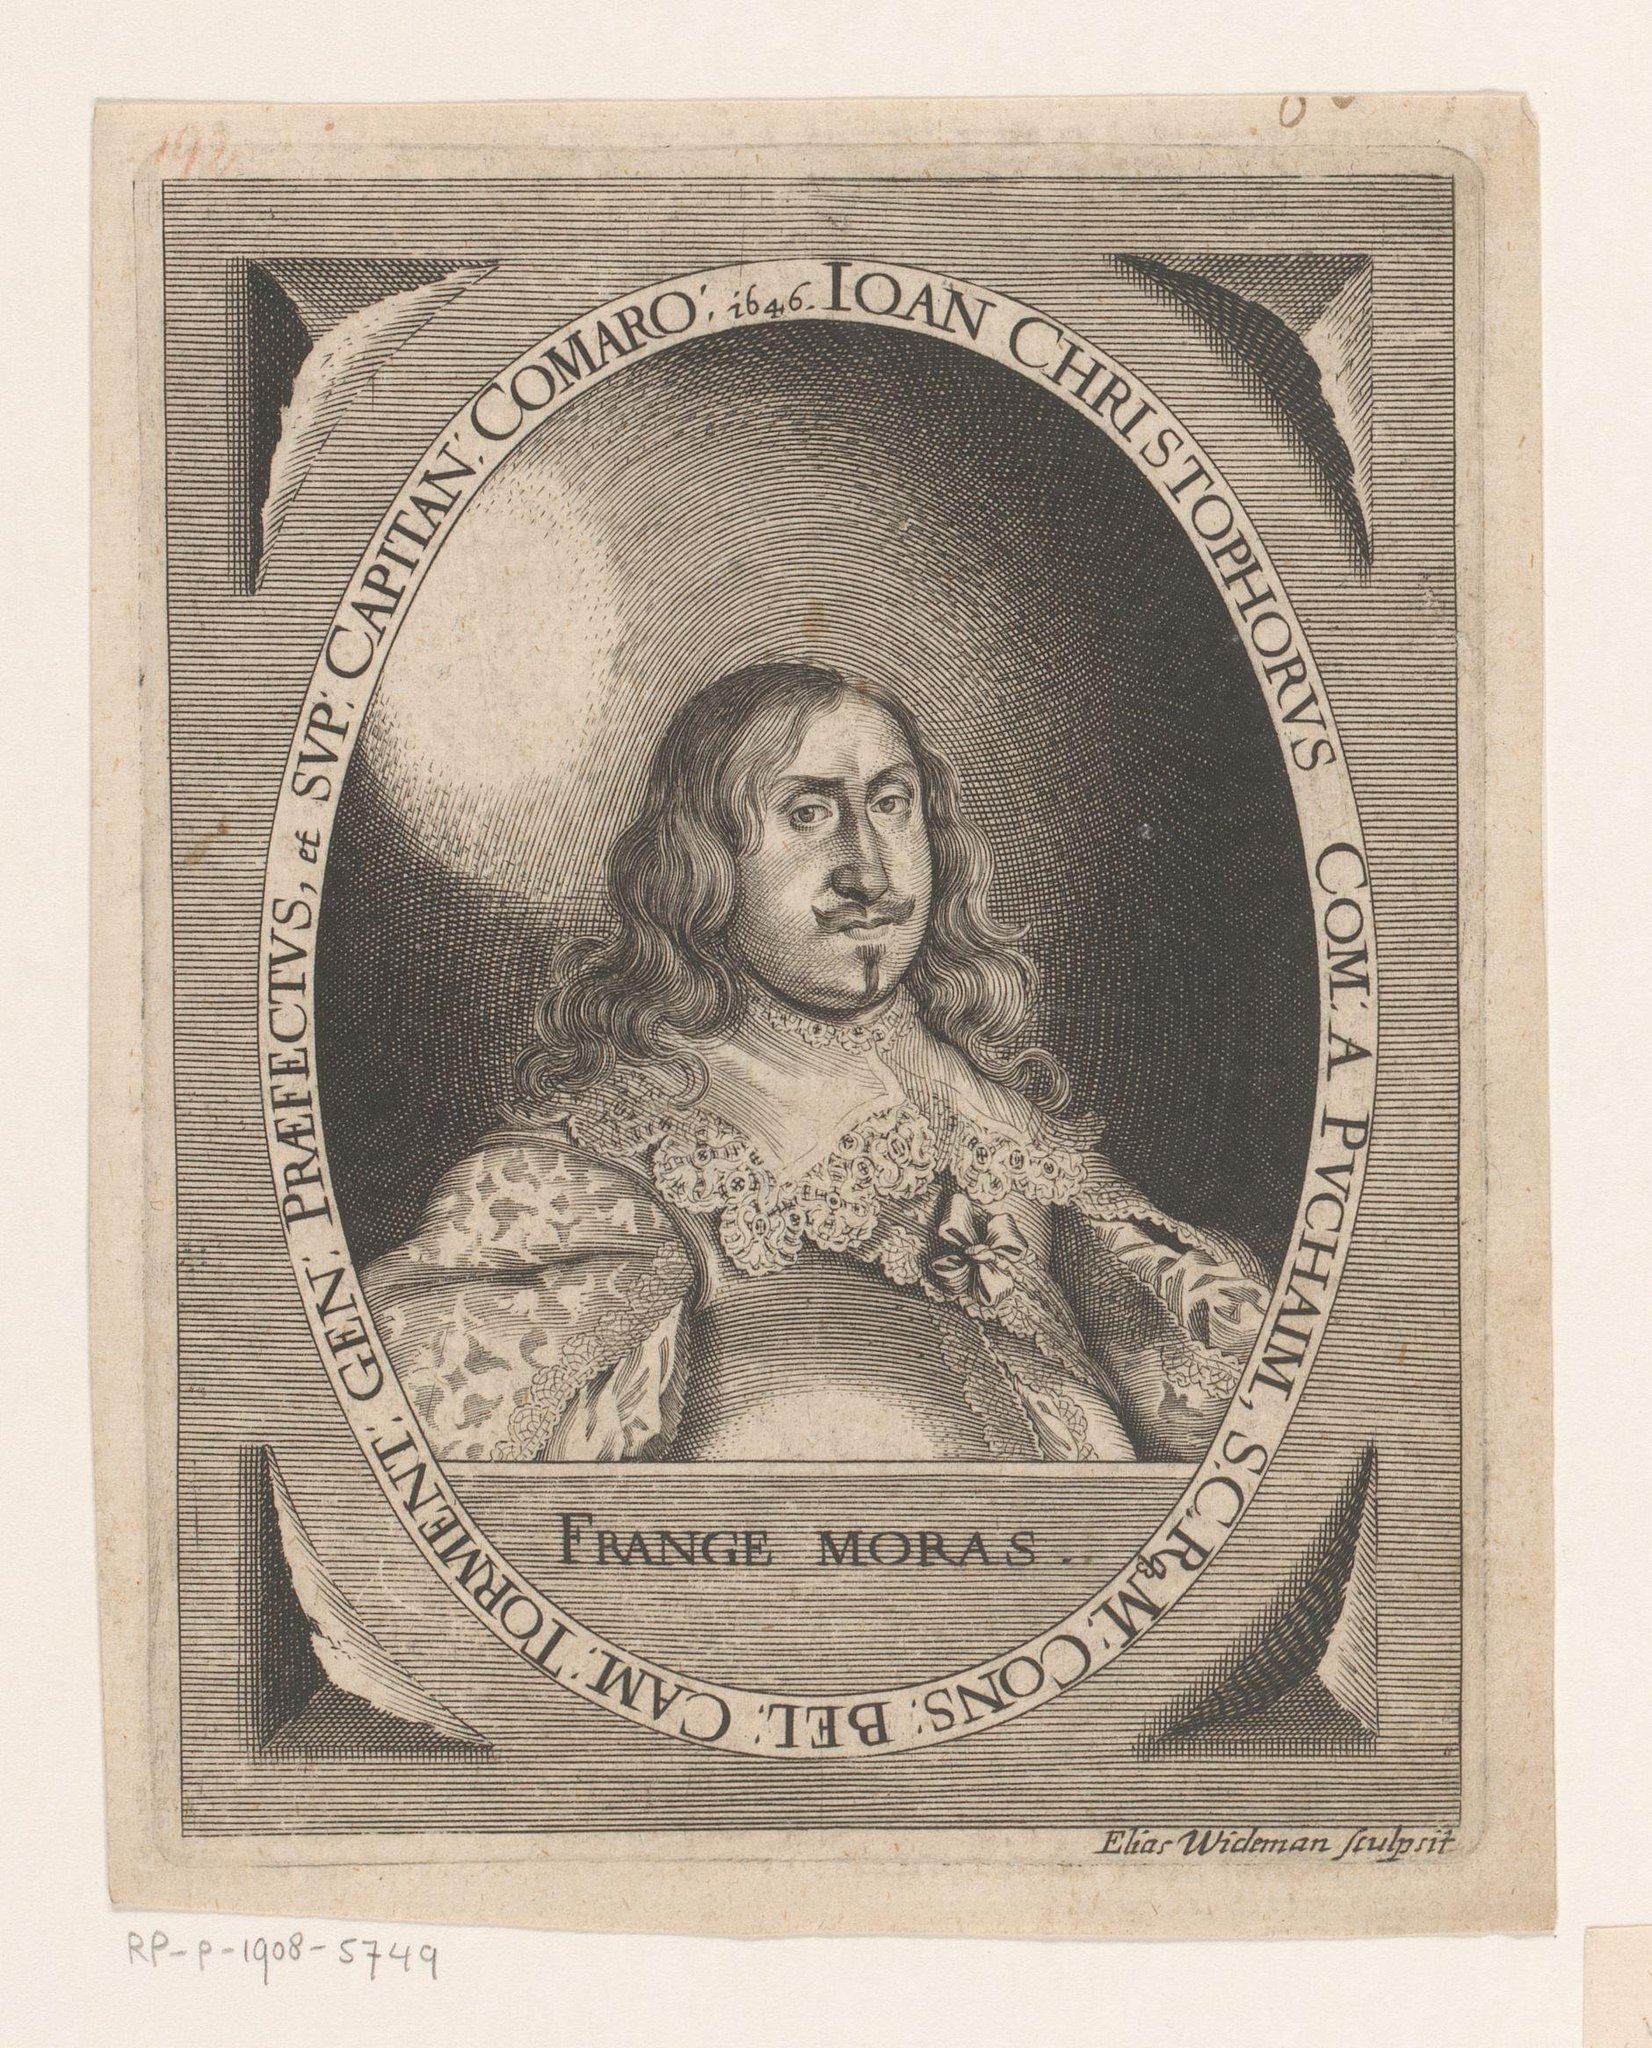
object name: print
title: Portret van Johann Christoph von Puchaim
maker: elias widemann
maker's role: print maker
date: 1646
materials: paper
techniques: engraving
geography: vienna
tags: historical persons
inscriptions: collector's mark: Lugt 2228